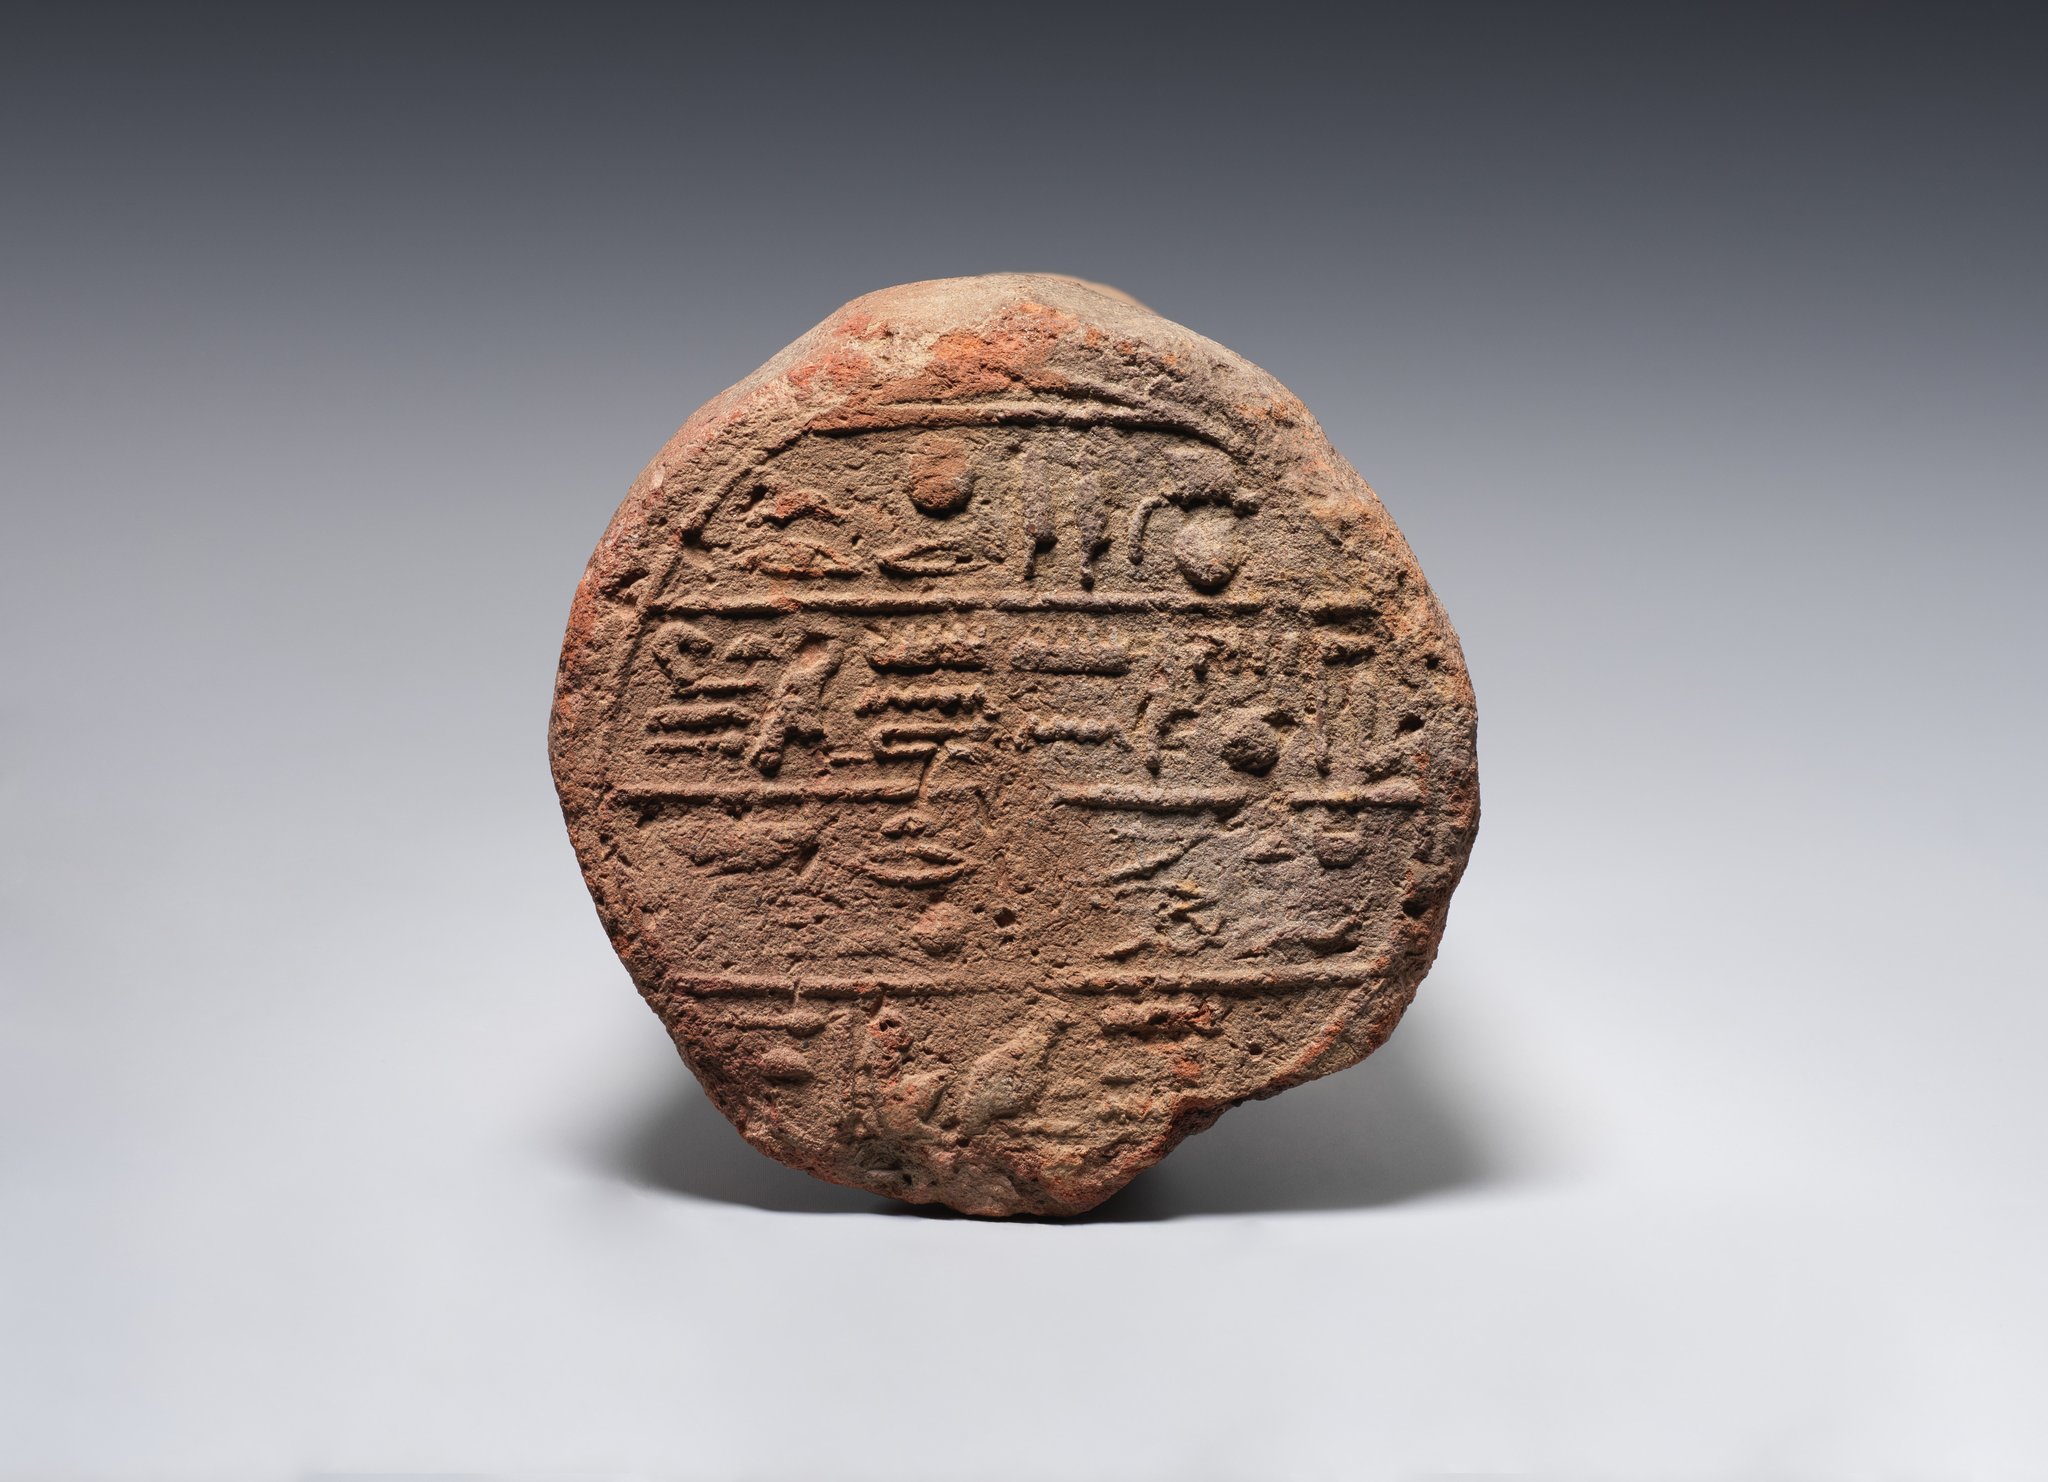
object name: cone, circular impression, montuemhat, shepenmut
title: Funerary Cone of Montuemhat and Shepenmut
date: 724-525 BCE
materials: pottery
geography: egypt